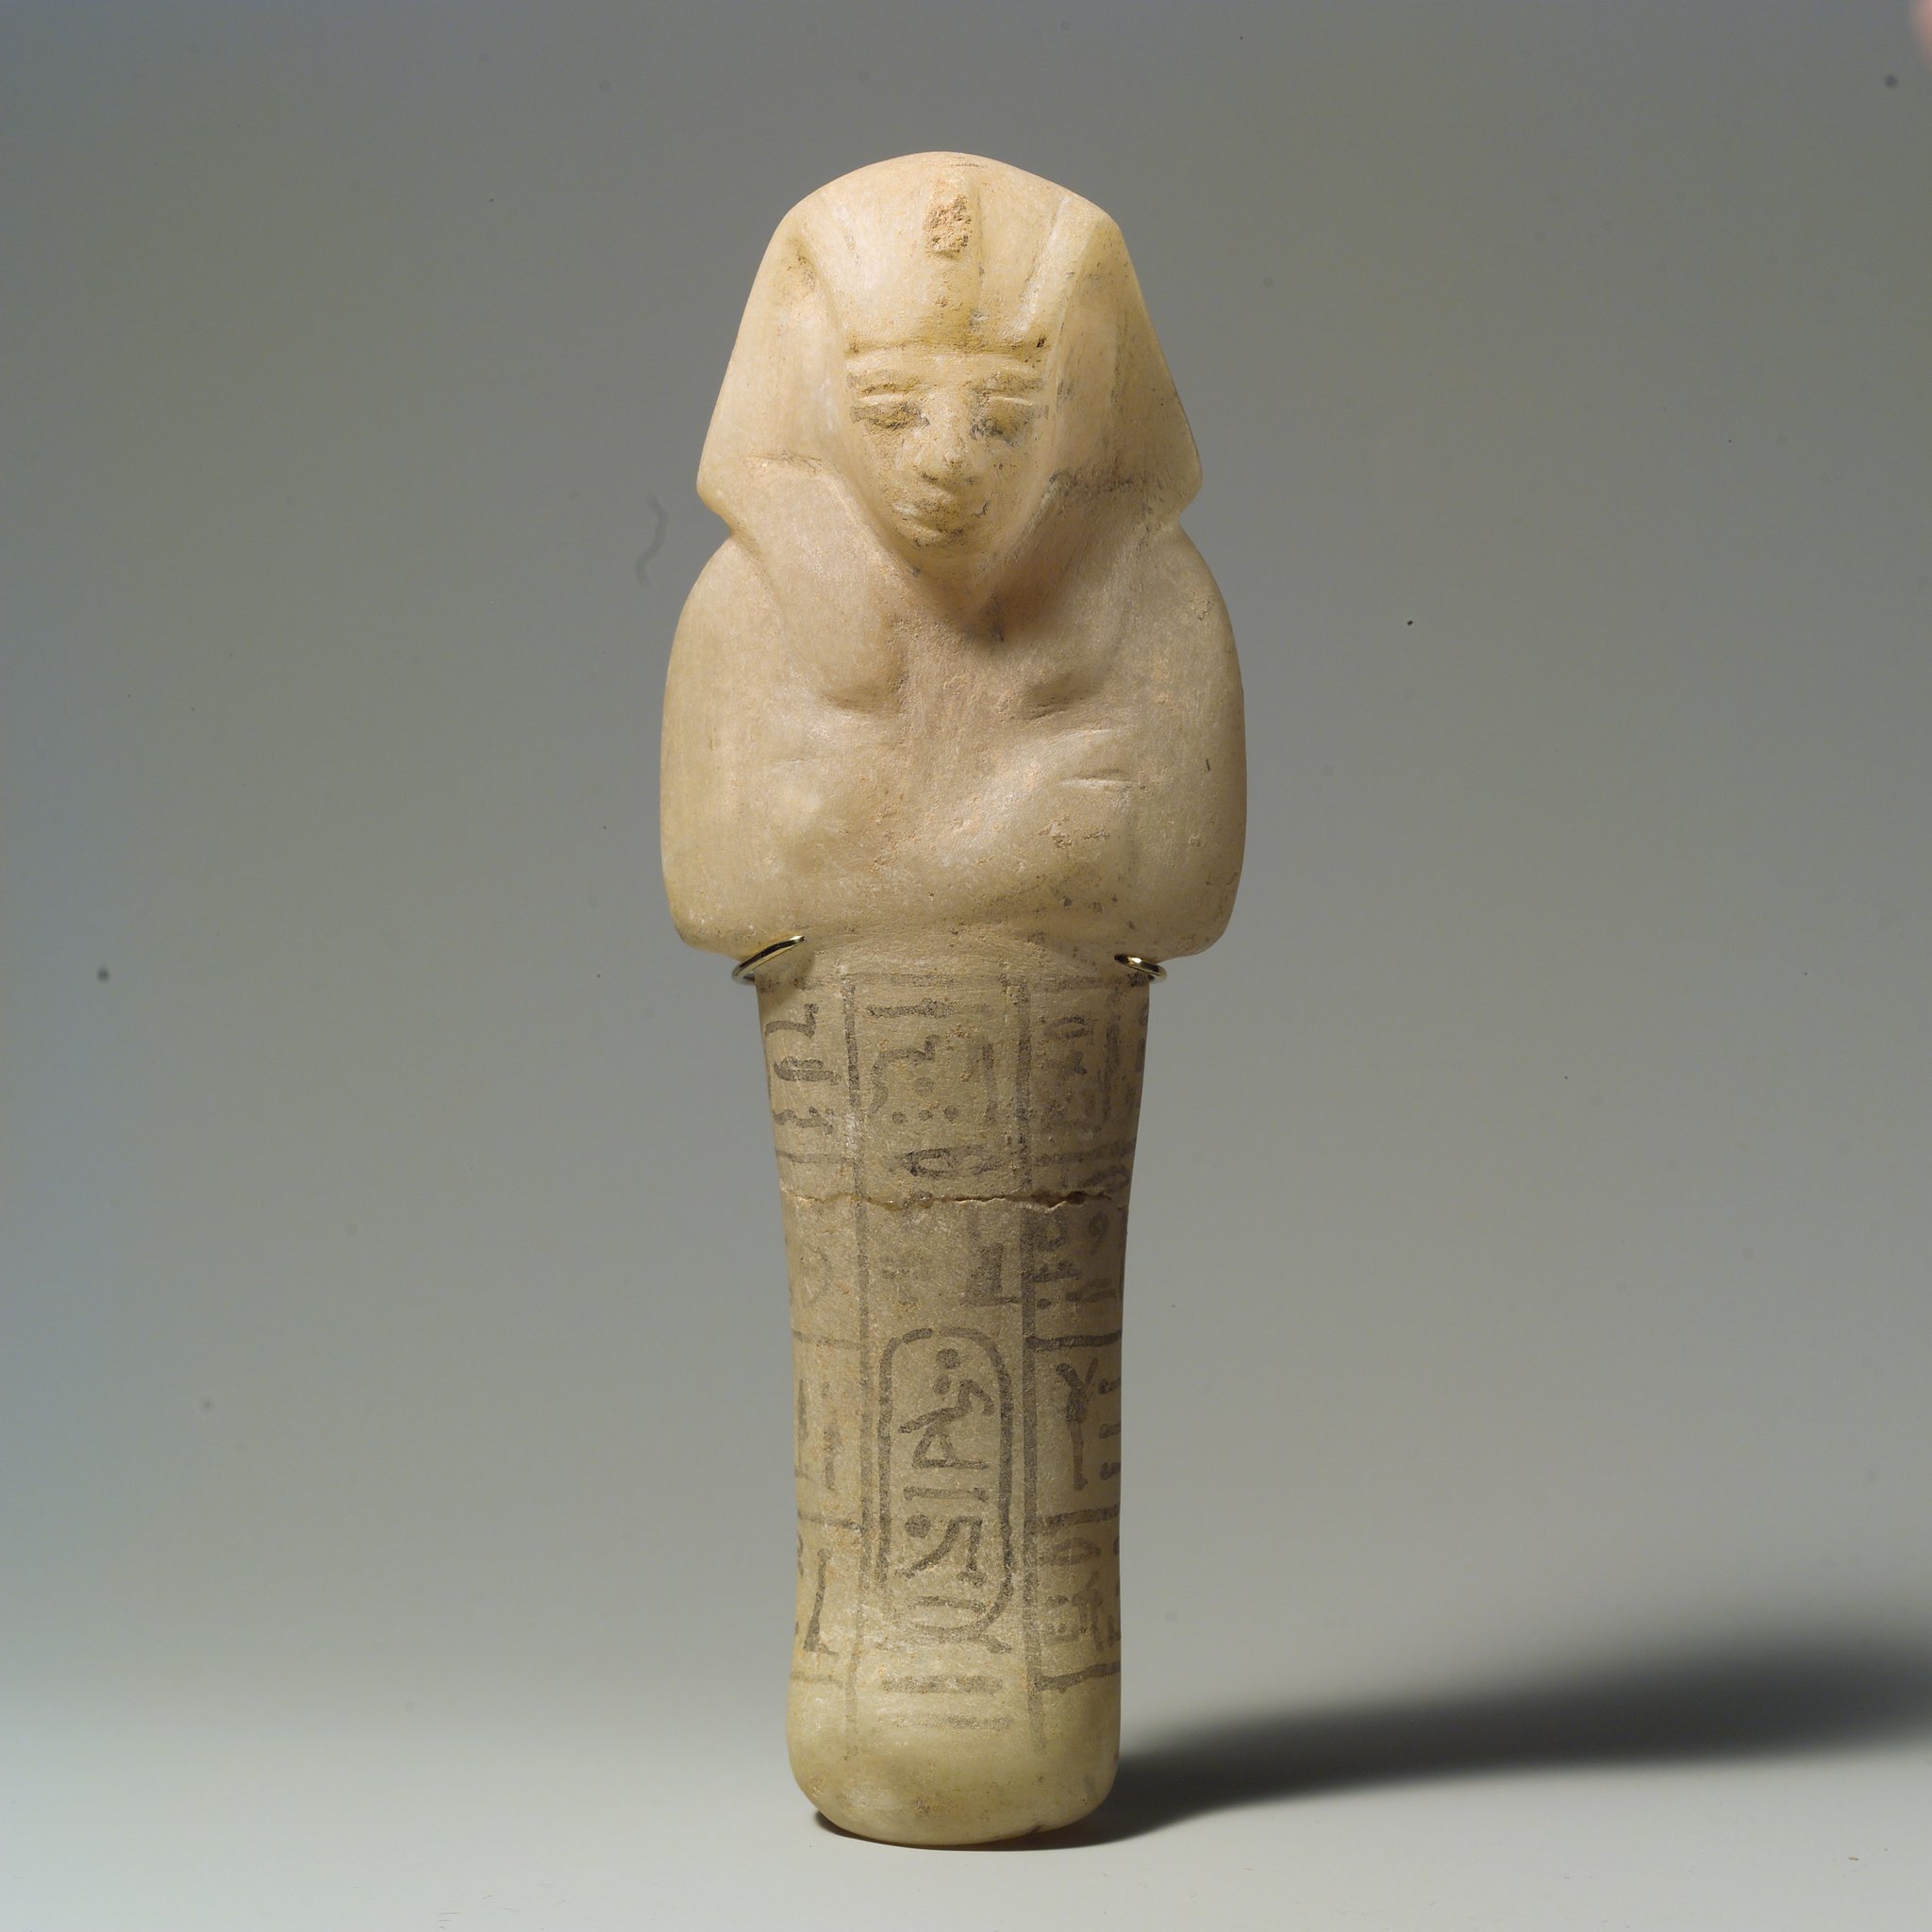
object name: shabti, siptah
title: Shabti of Siptah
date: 1194-1188 BCE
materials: paint, stone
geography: egypt